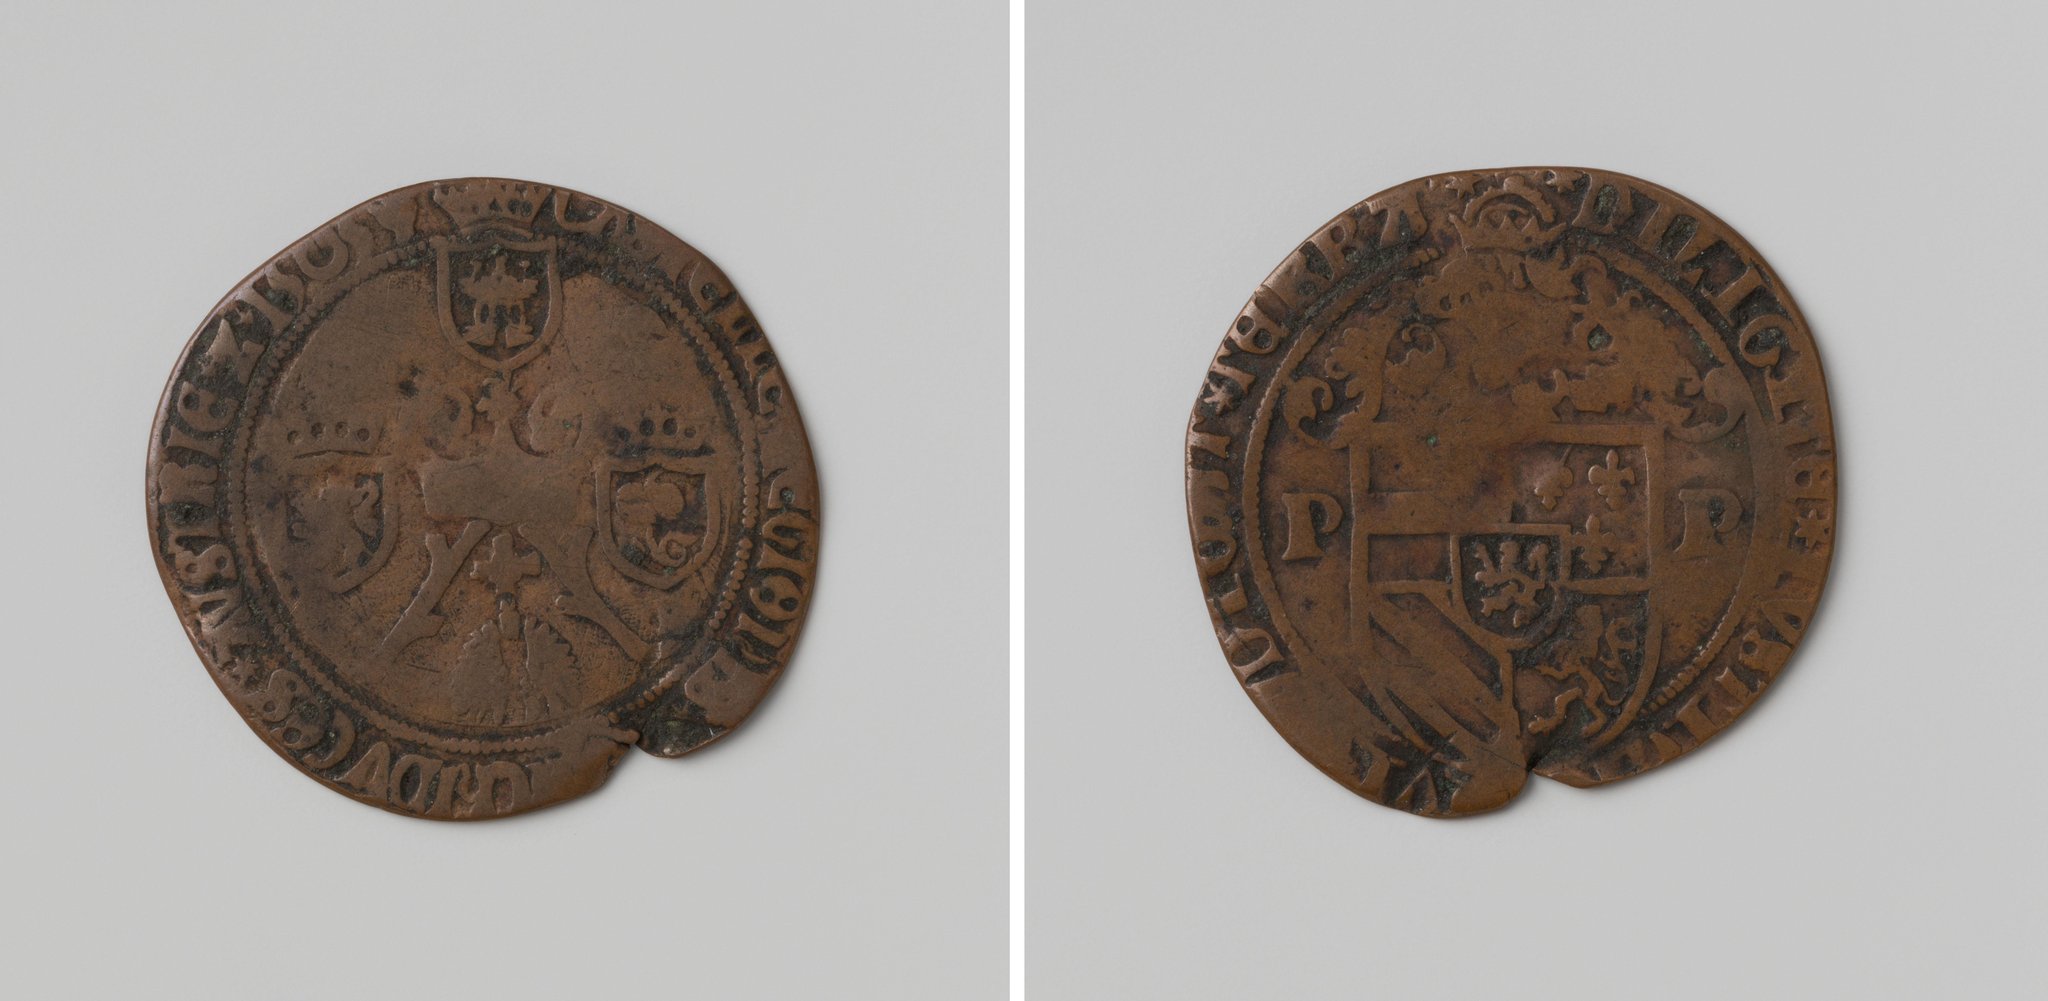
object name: jeton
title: Filips de Schone, koning van Leon en Castilie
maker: Anonymous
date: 1505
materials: copper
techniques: striking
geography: antwerp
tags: filips de schone (hertog van bourgondië)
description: Koperen penning. Voorzijde: vuurslag, waaraan Gulden Vlies hangt, op Bourgondisch kruis; daarboven, en aan weerszijden: gekroond wapenschild binnen omschrift. Keerzijde: wapenschild, geflankeerd door twee letters P onder gekroonde helm binnen omschrift